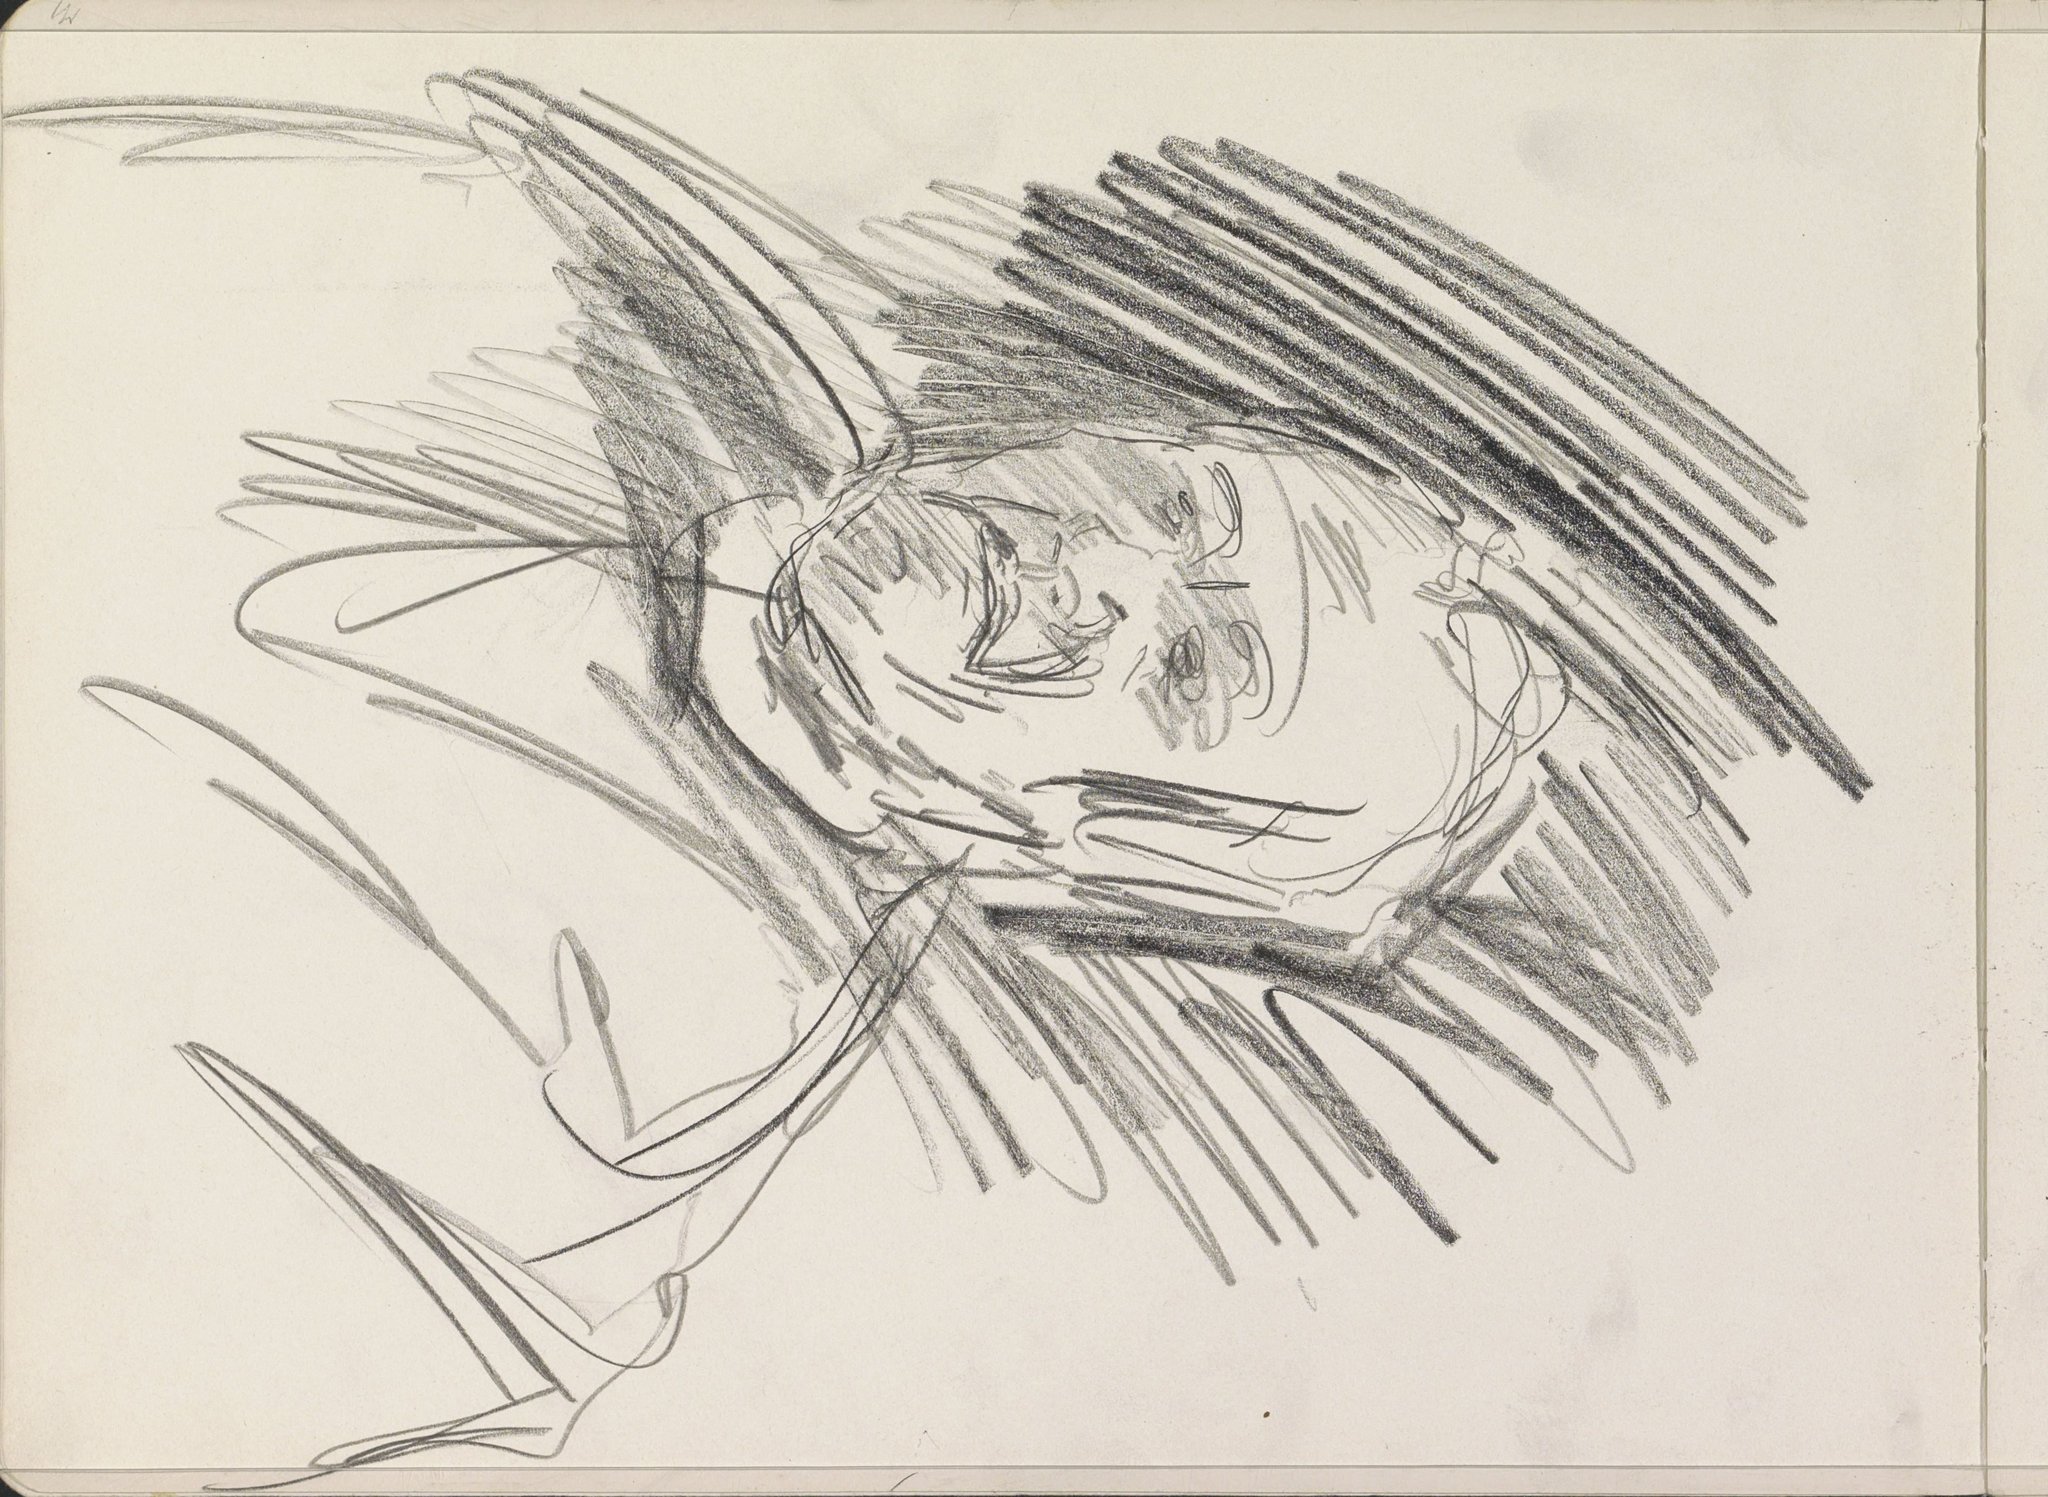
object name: sketchbook leaf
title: Portret van een onbekende man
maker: isaac israels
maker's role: draughtsman, painter, print maker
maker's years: 1865-1934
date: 1915-1934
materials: paper, pencil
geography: the hague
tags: anonymous historical person portrayed alone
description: Blad 2 verso uit schetsboek III met 36 bladen.